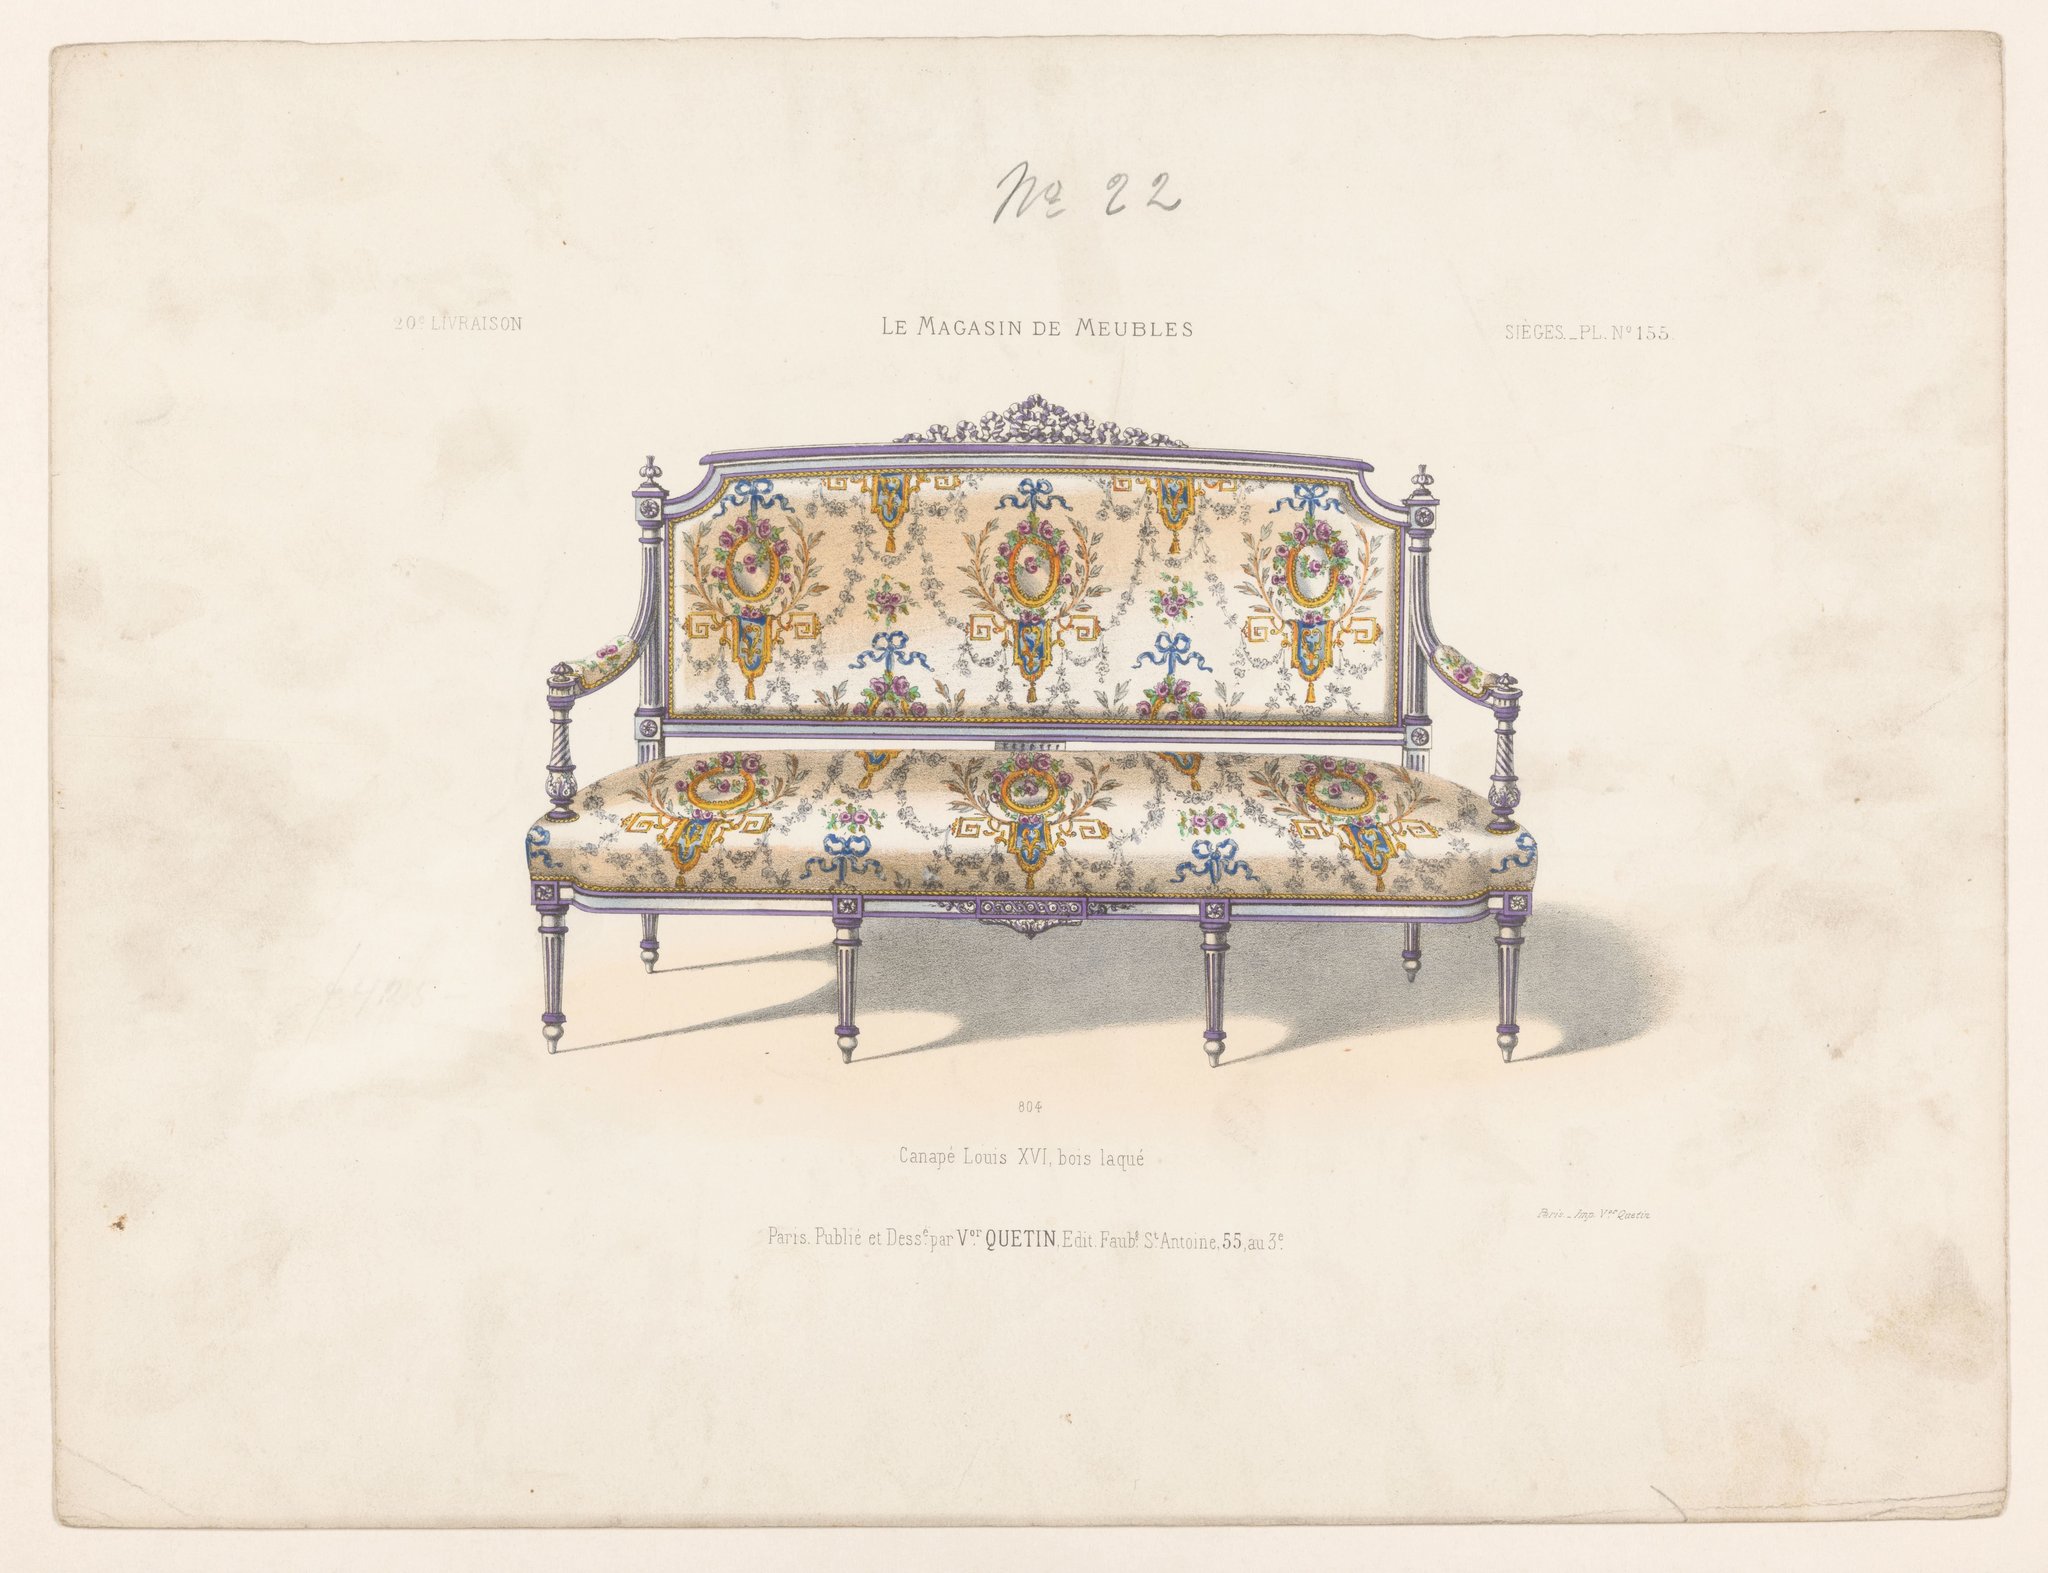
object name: print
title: Canapé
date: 1832-1877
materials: paper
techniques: hand coloring, lithograph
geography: paris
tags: seating furniture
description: Een canapé in de Lodewijk XVI-stijl. Prent uit 20e Livraison.